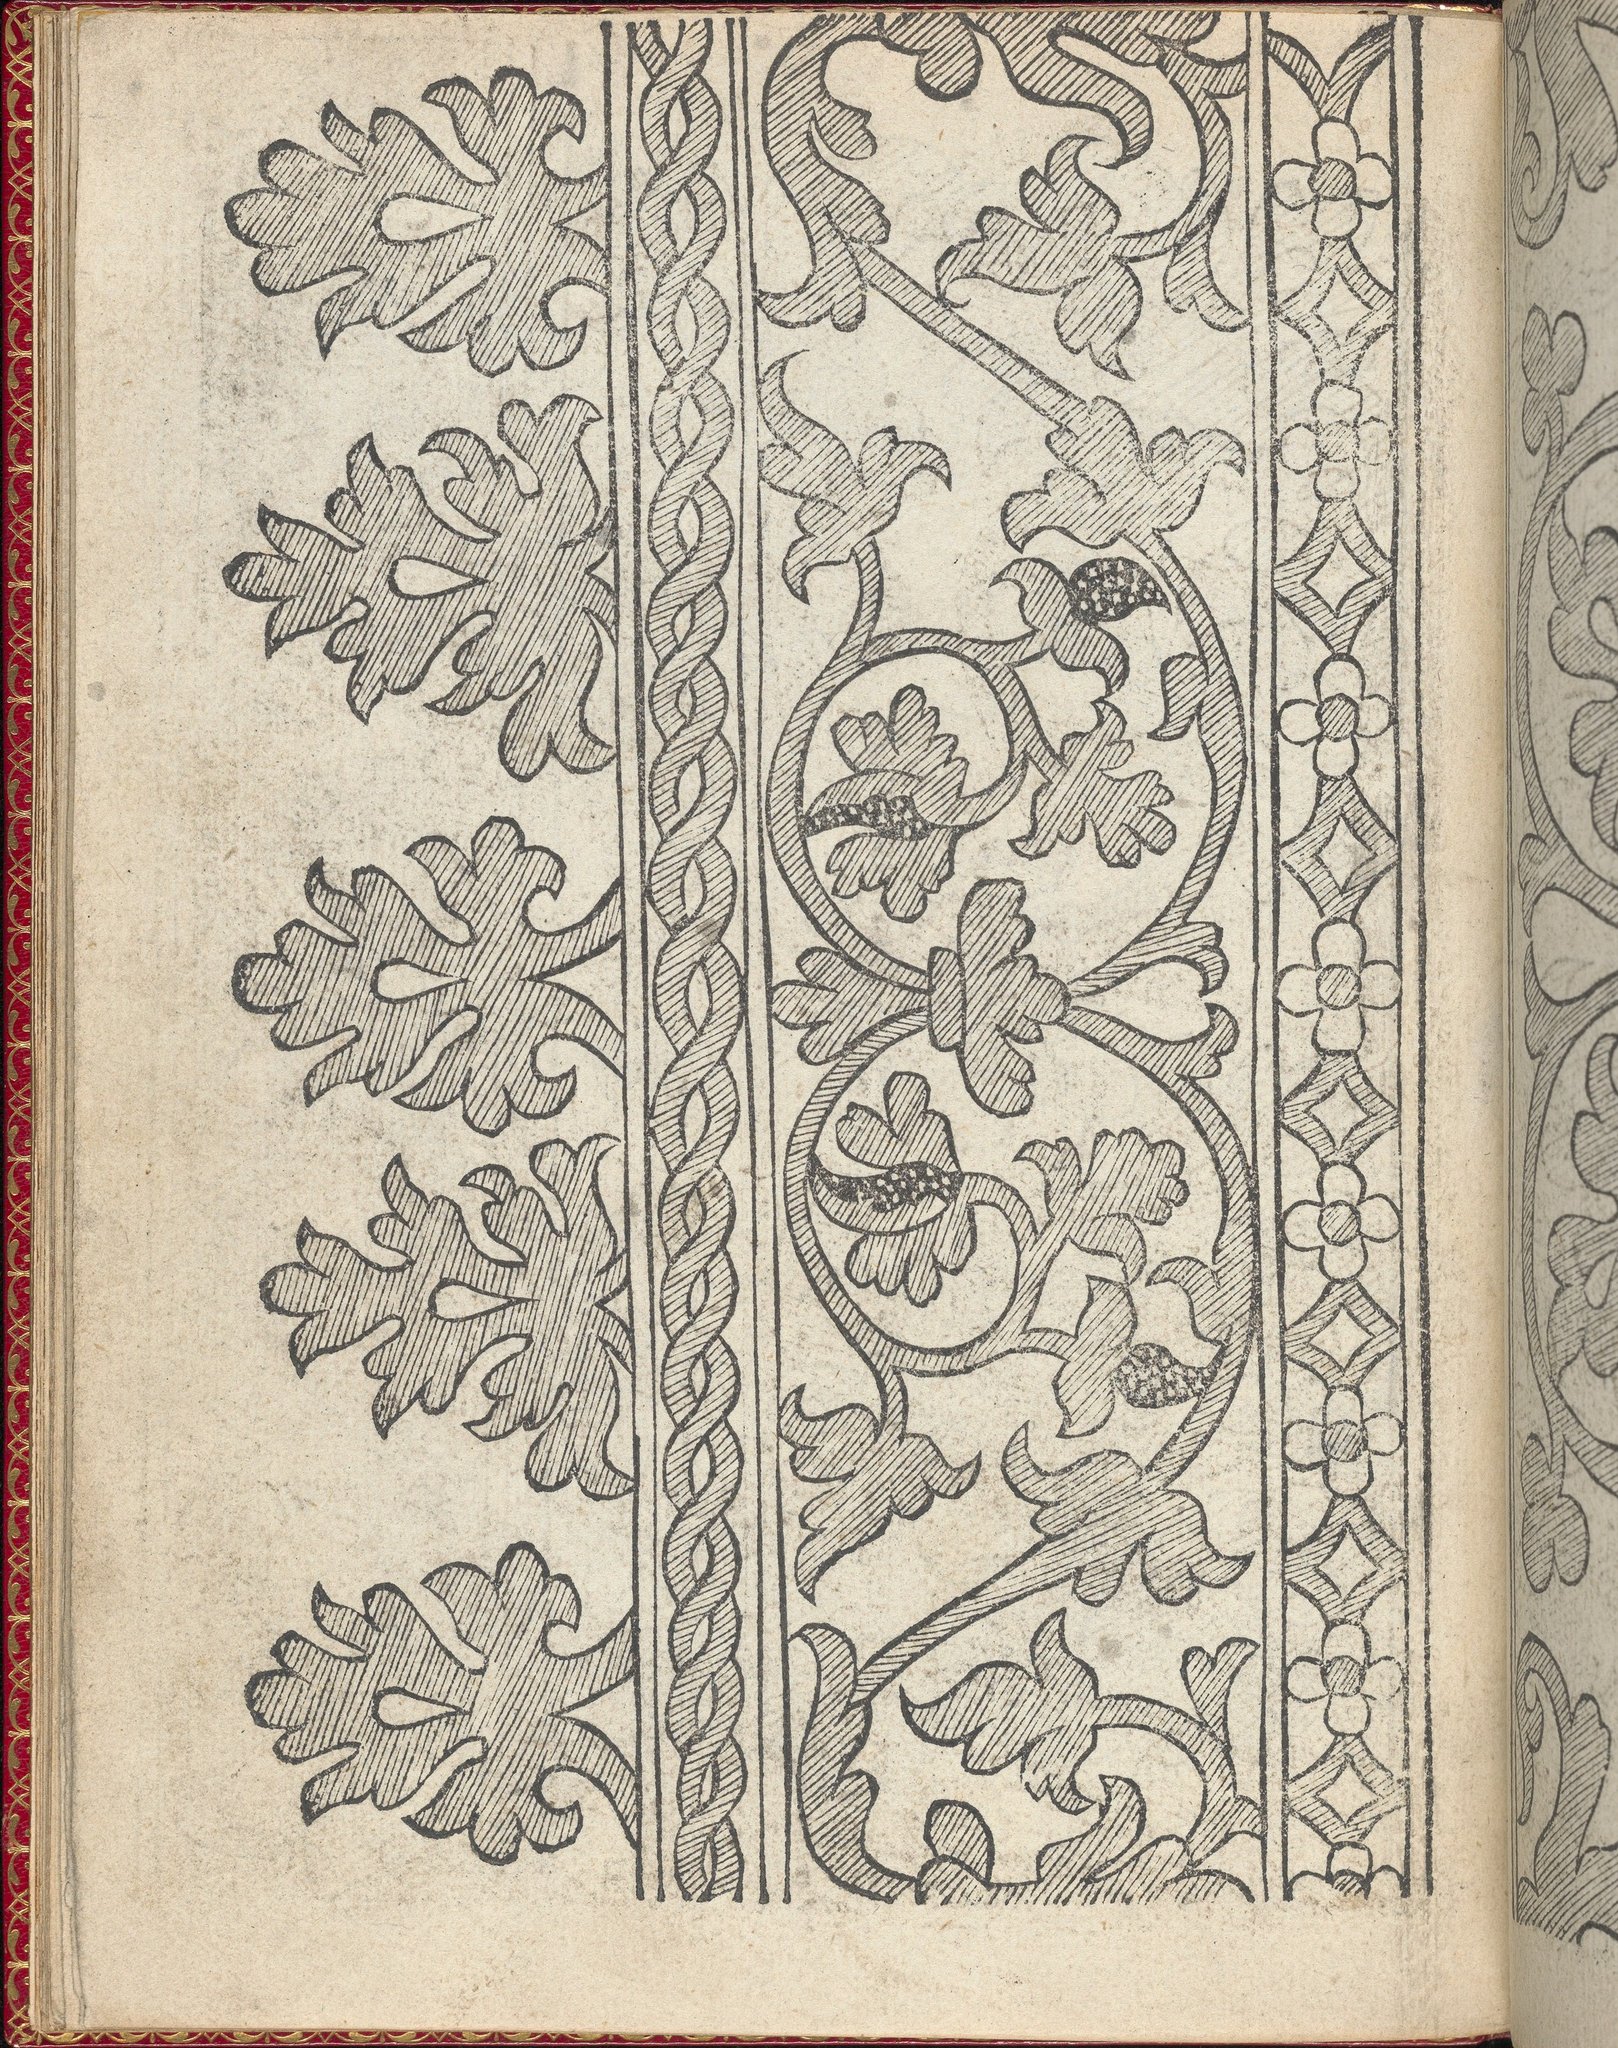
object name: book print ornament architecture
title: Il Monte. Opera Nova di Recami, page 10 (verso)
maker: giovanni antonio bindoni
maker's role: designer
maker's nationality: italian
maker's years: 1500-1650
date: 1557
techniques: woodcut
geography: italy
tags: fruit